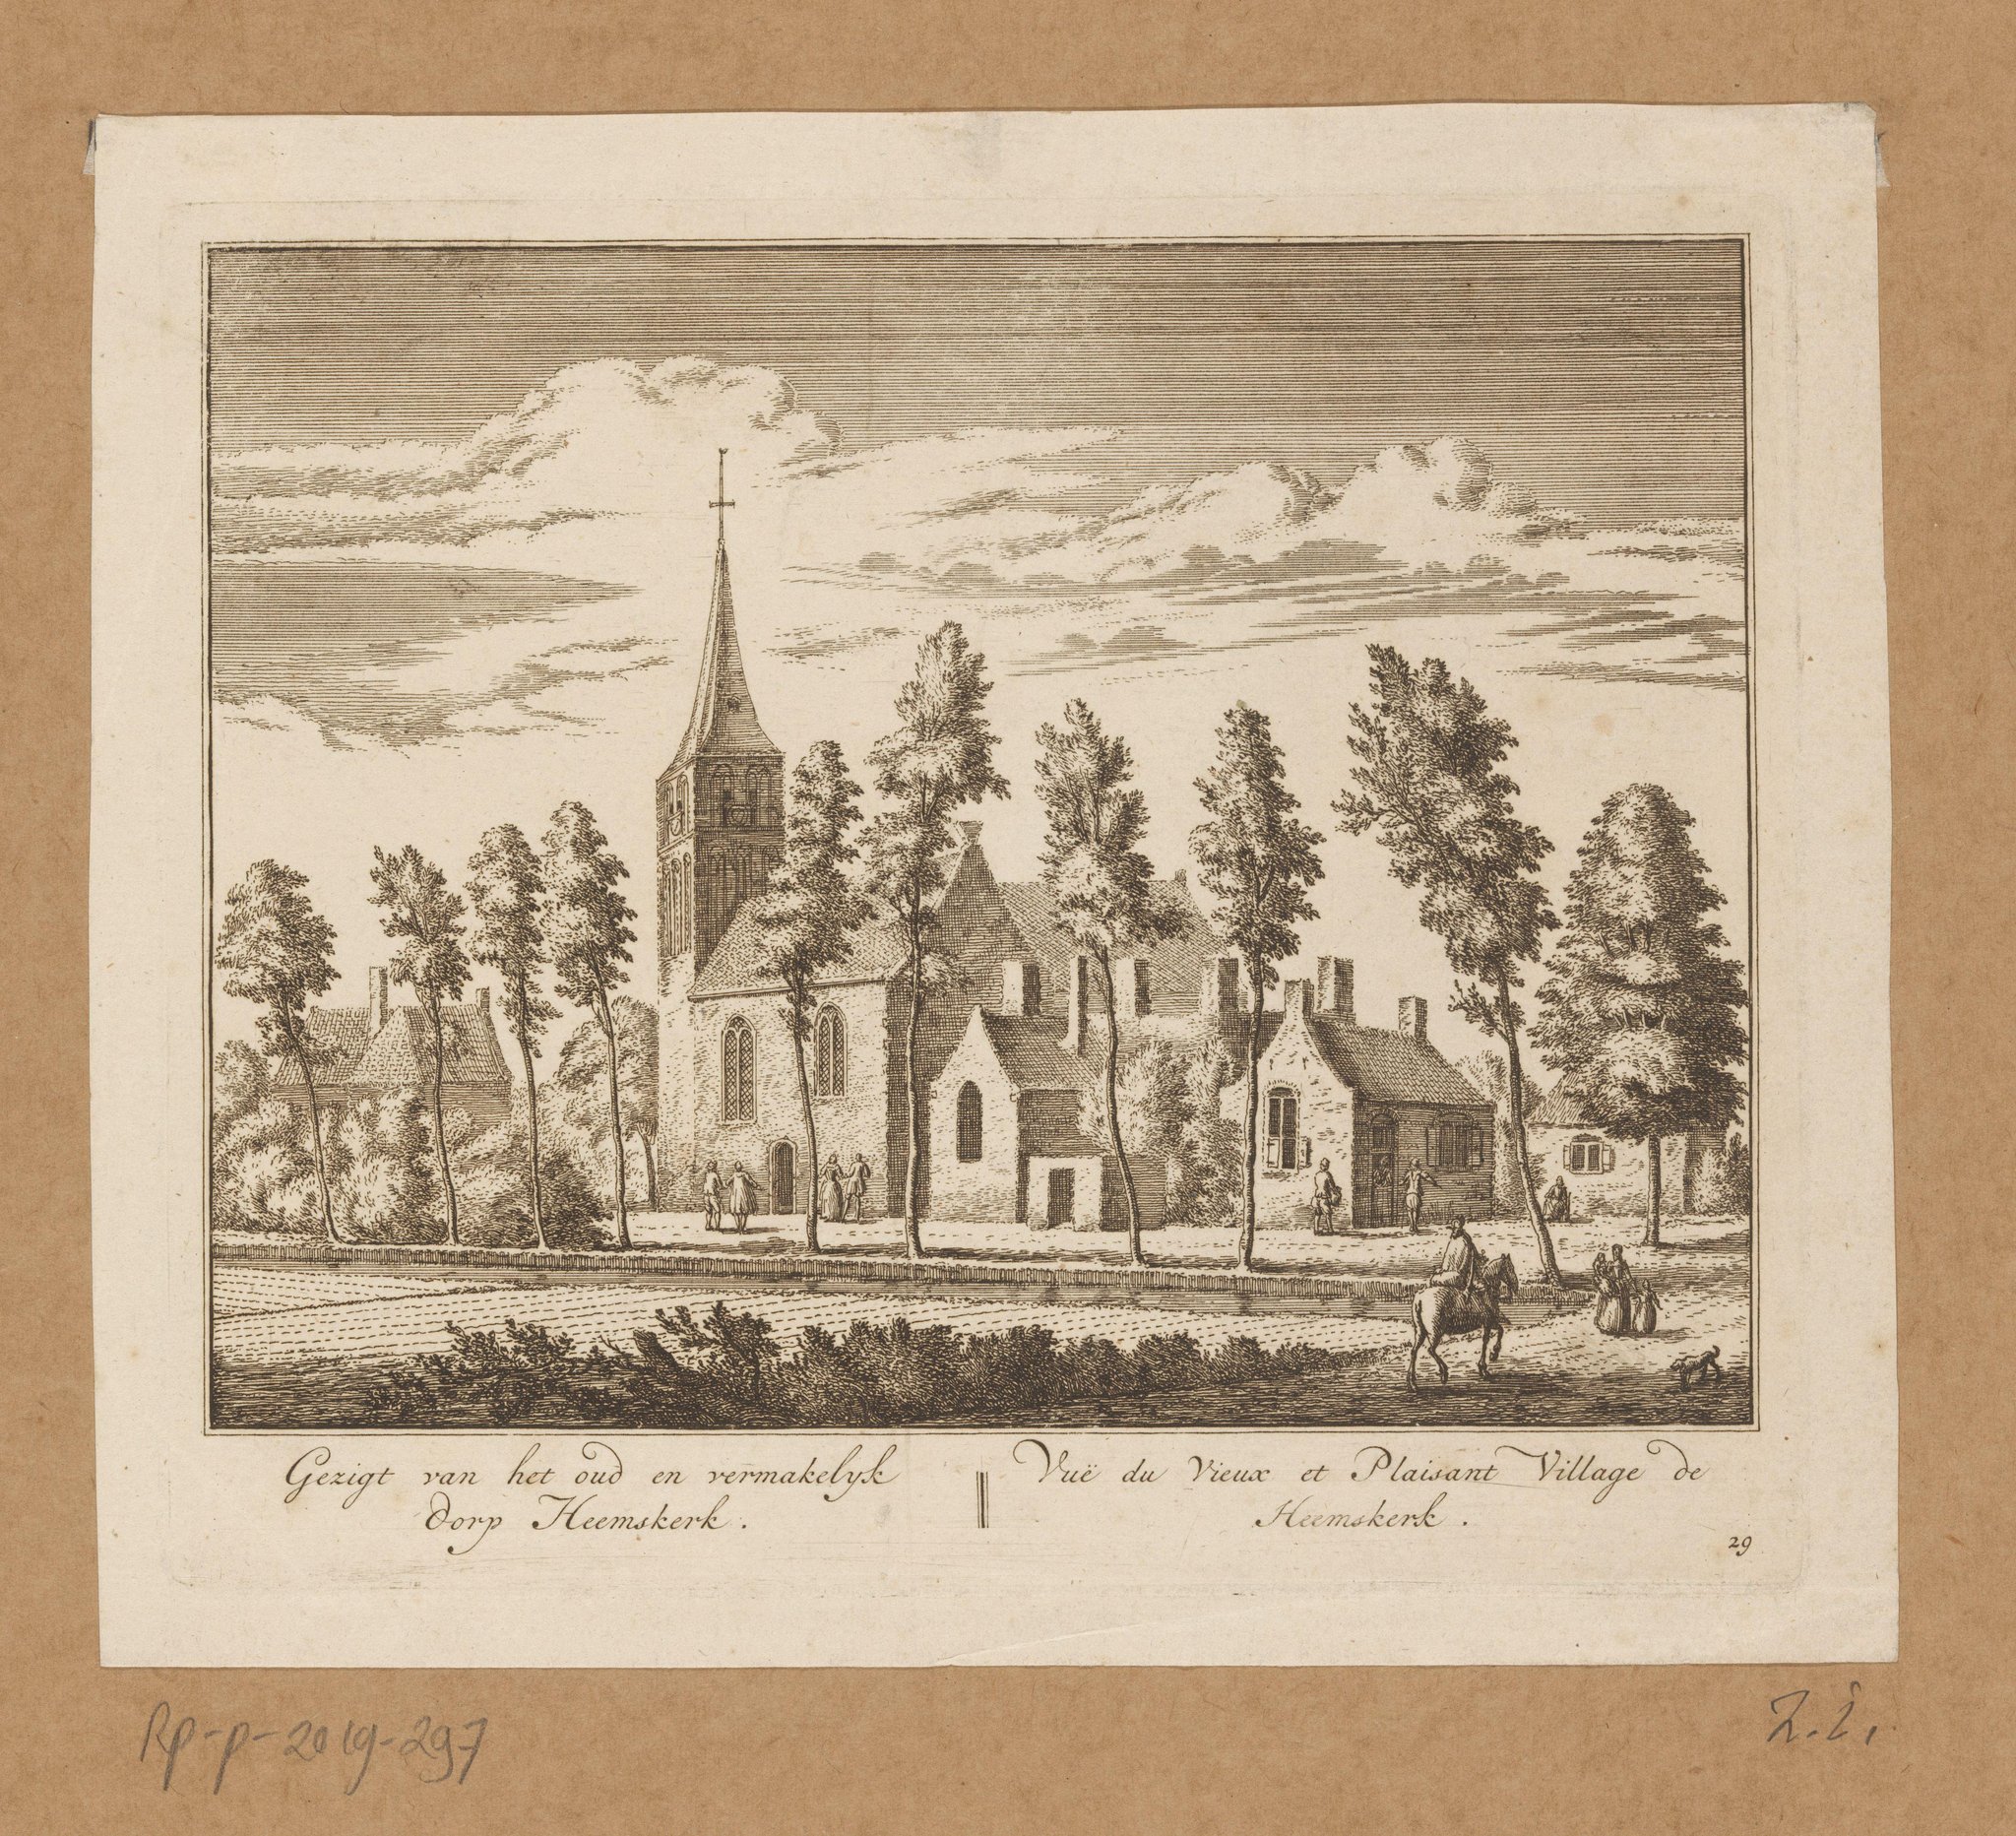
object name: print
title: Gezicht op de dorpskerk van Heemskerk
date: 1728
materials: paper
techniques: etching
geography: amsterdam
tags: prospect of village, silhouette of village, church (exterior), public road in village (+ city(-scape) with figures, staffage)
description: Prent uit: Rademaker, Abraham. Hollands Tempe verherelykt, vertoond in dertig uitmuntende gezigten; beginnende van Amsterdam (…) / La Hollande et tout son eclat et beauté, remontrée par trente exellentes vues, commençant d'Amsterdam (…). Amsterdam: Leonard Schenk, 1728.